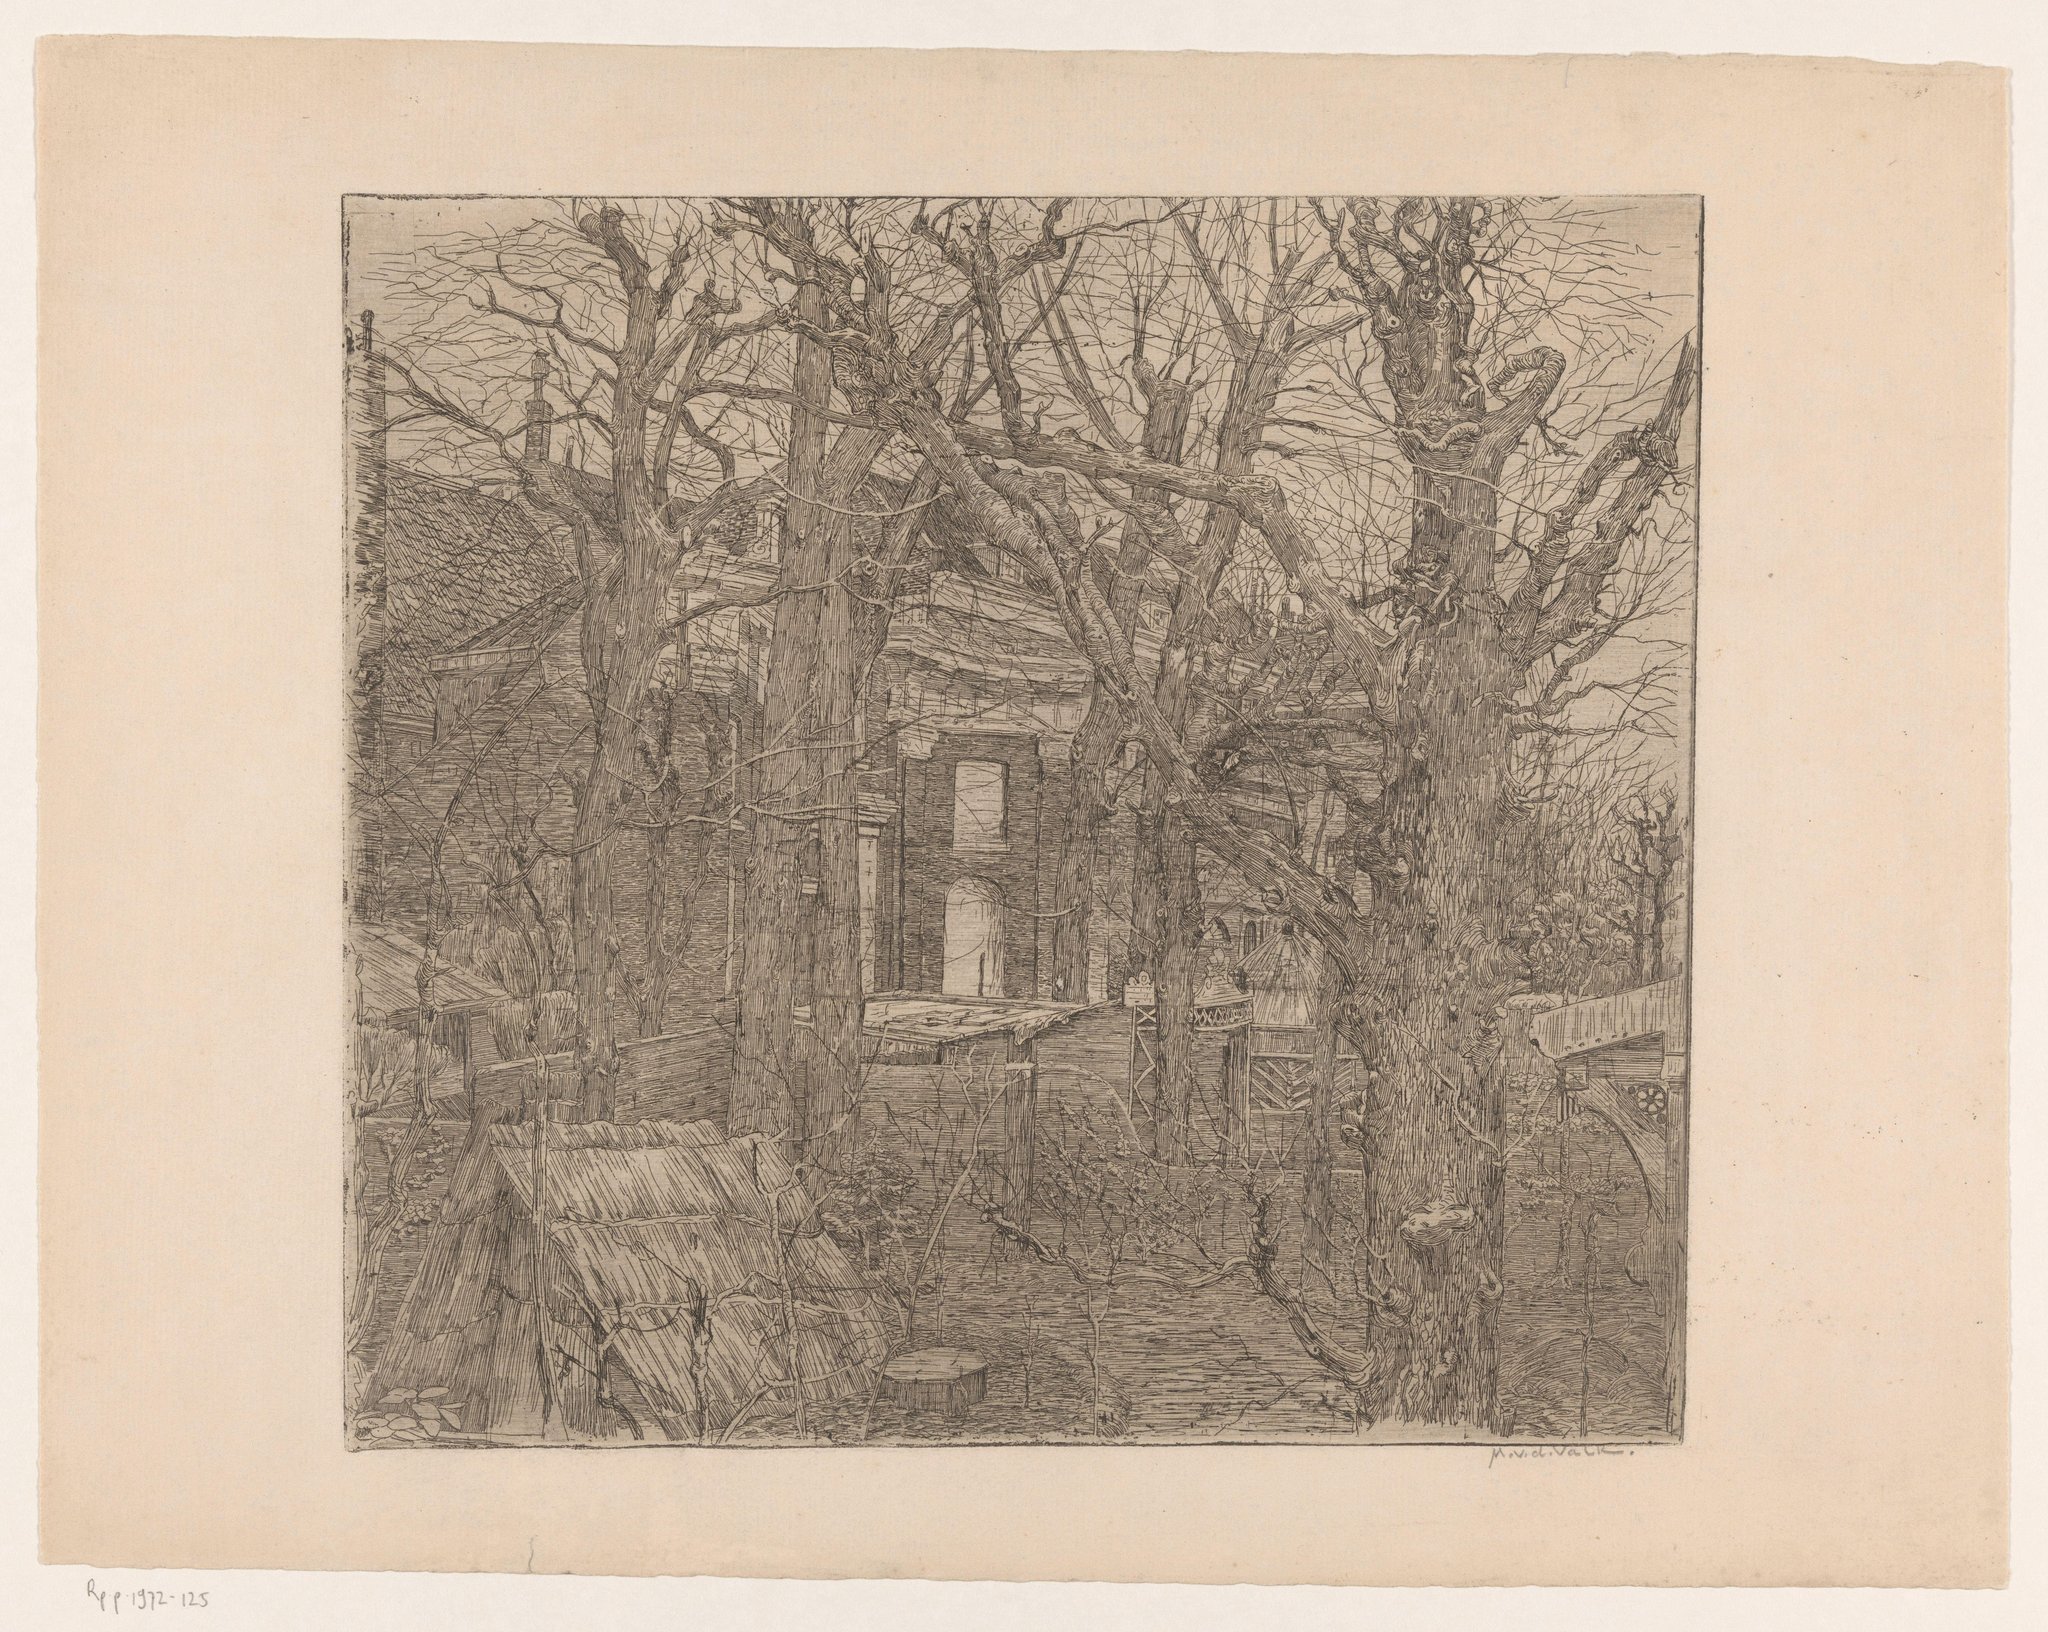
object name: print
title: Tuin in Amsterdam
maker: maurits van der valk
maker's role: draughtsman, print maker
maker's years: 1857-1935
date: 1867-1935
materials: paper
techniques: etching, intaglio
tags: trees, villa, amsterdam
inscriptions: collector's mark: Lugt 2760, collector's mark: Lugt 3623, collector's mark: Lugt 2228